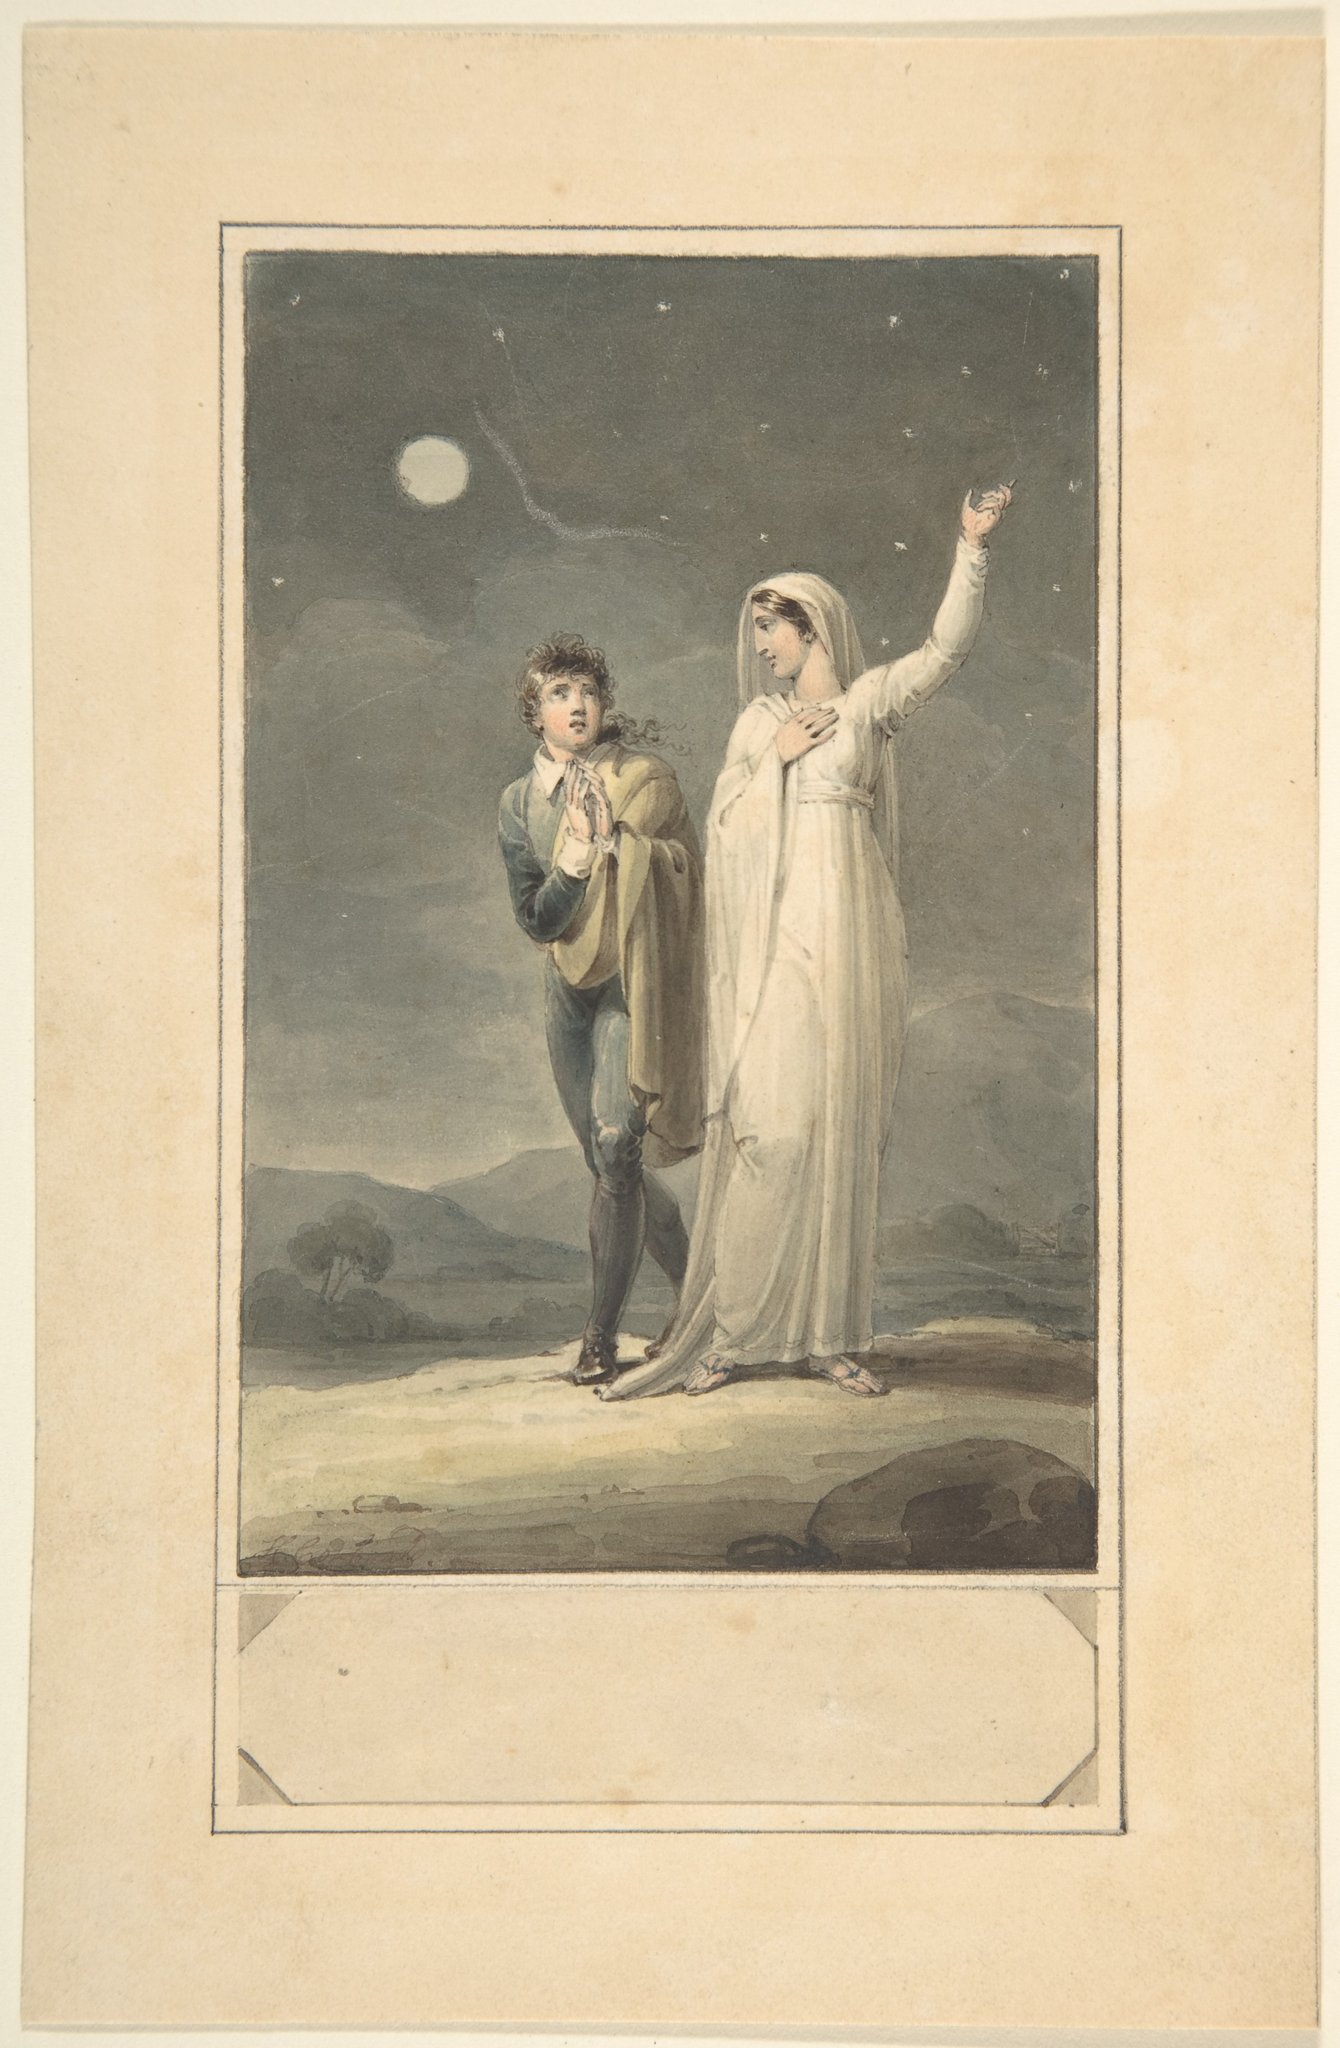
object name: drawing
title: Nocturnal Landscape with Two Figures (design for an engraved book illustration)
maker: henry corbould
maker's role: artist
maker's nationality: british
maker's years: 1787-1844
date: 1807-1844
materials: graphite, ink, watercolor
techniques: pen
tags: men,women,moon